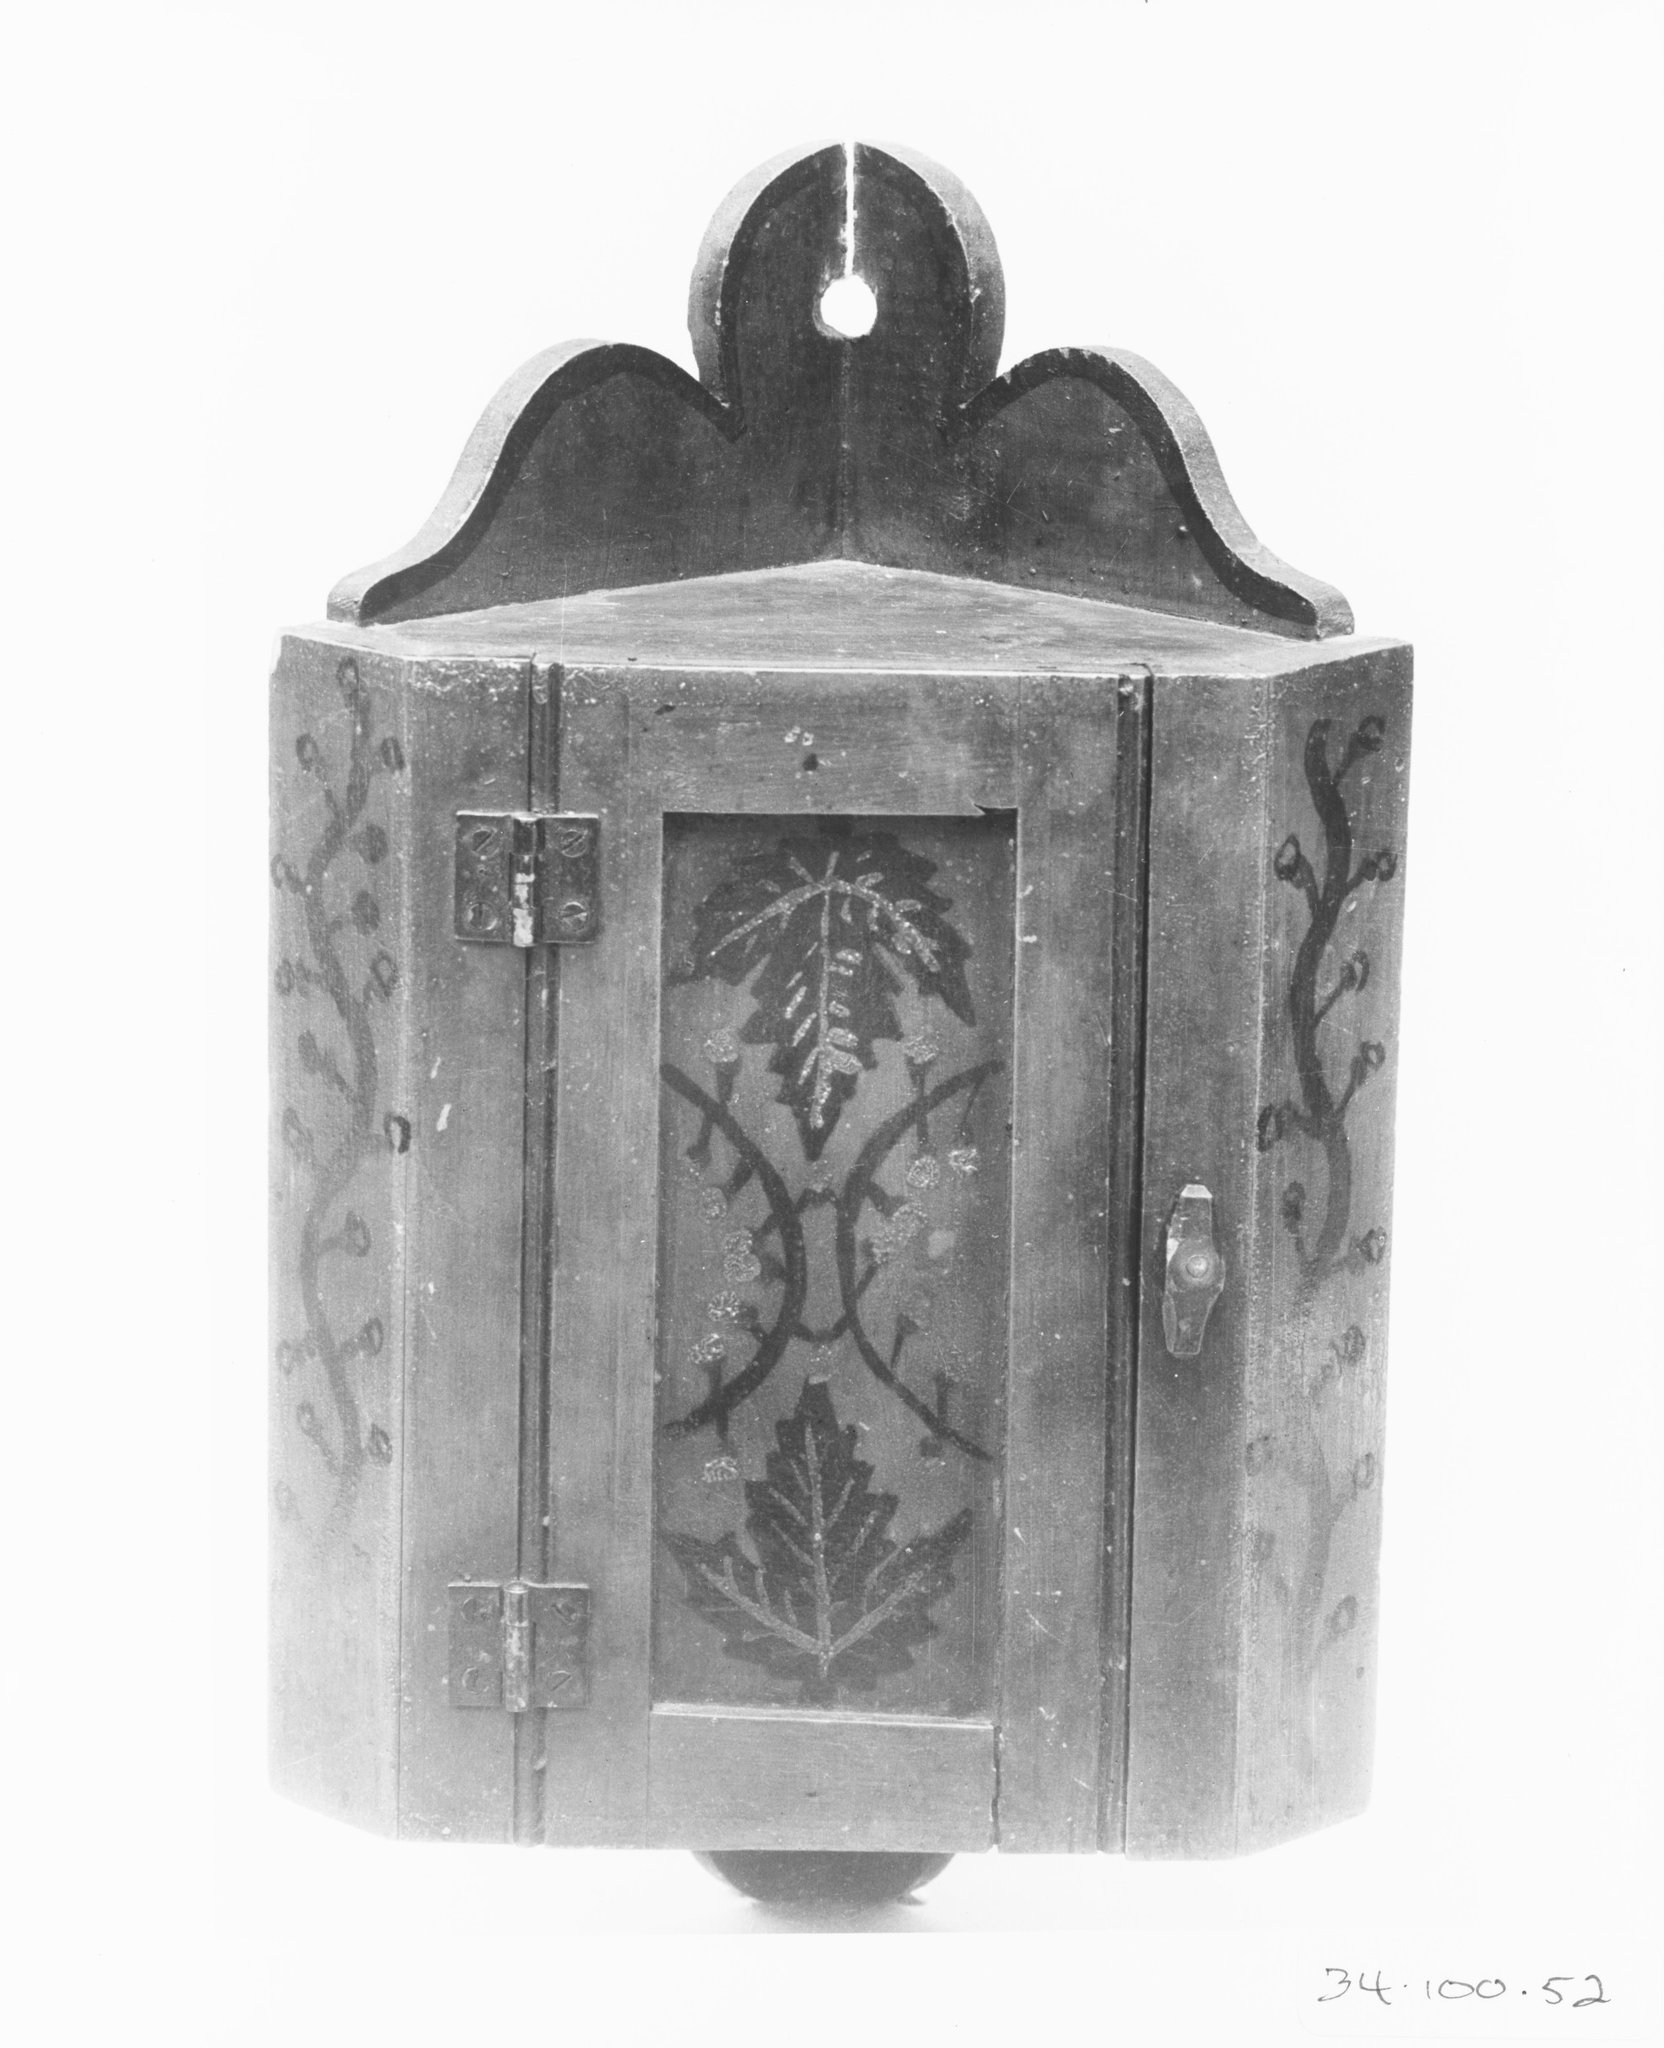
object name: key cupboard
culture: american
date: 1800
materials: wood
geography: united states